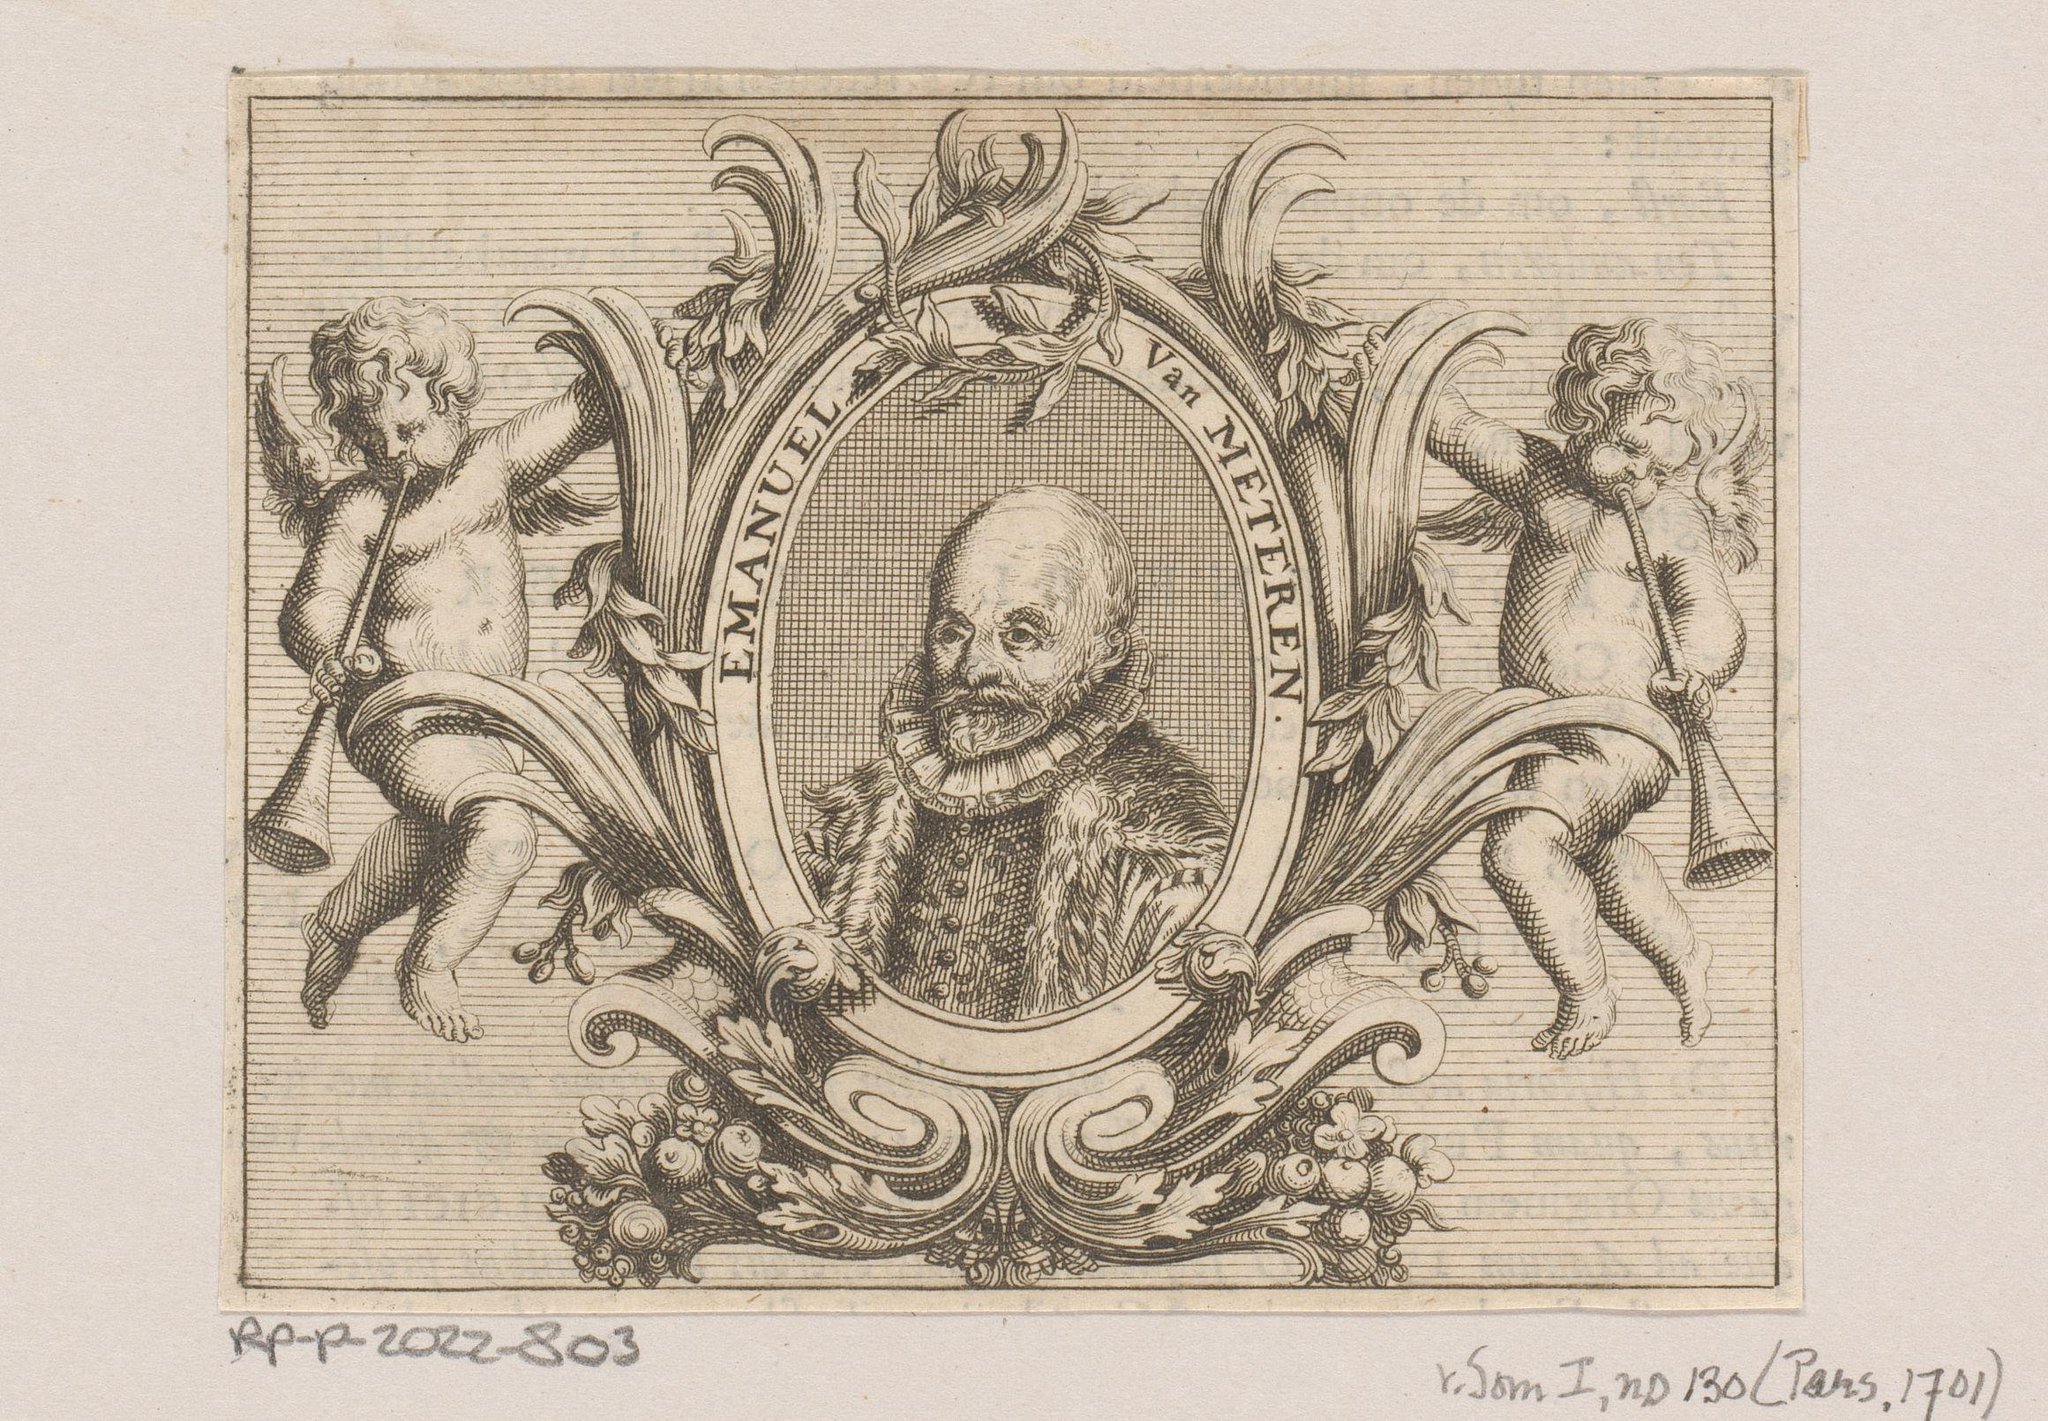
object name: book illustration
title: Emanuel Van Meteren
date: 1701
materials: paper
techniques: engraving, etching, letterpress printing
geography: leiden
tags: london, emanuel van meteren, historical persons, portrait of a writer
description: Prent uit: Pars, Adriaan. Index Batavicus, of Naamrol van de Batavise en Hollandse schrijvers. (...) Leiden: Abraham de Swart, 1701, p. 262.